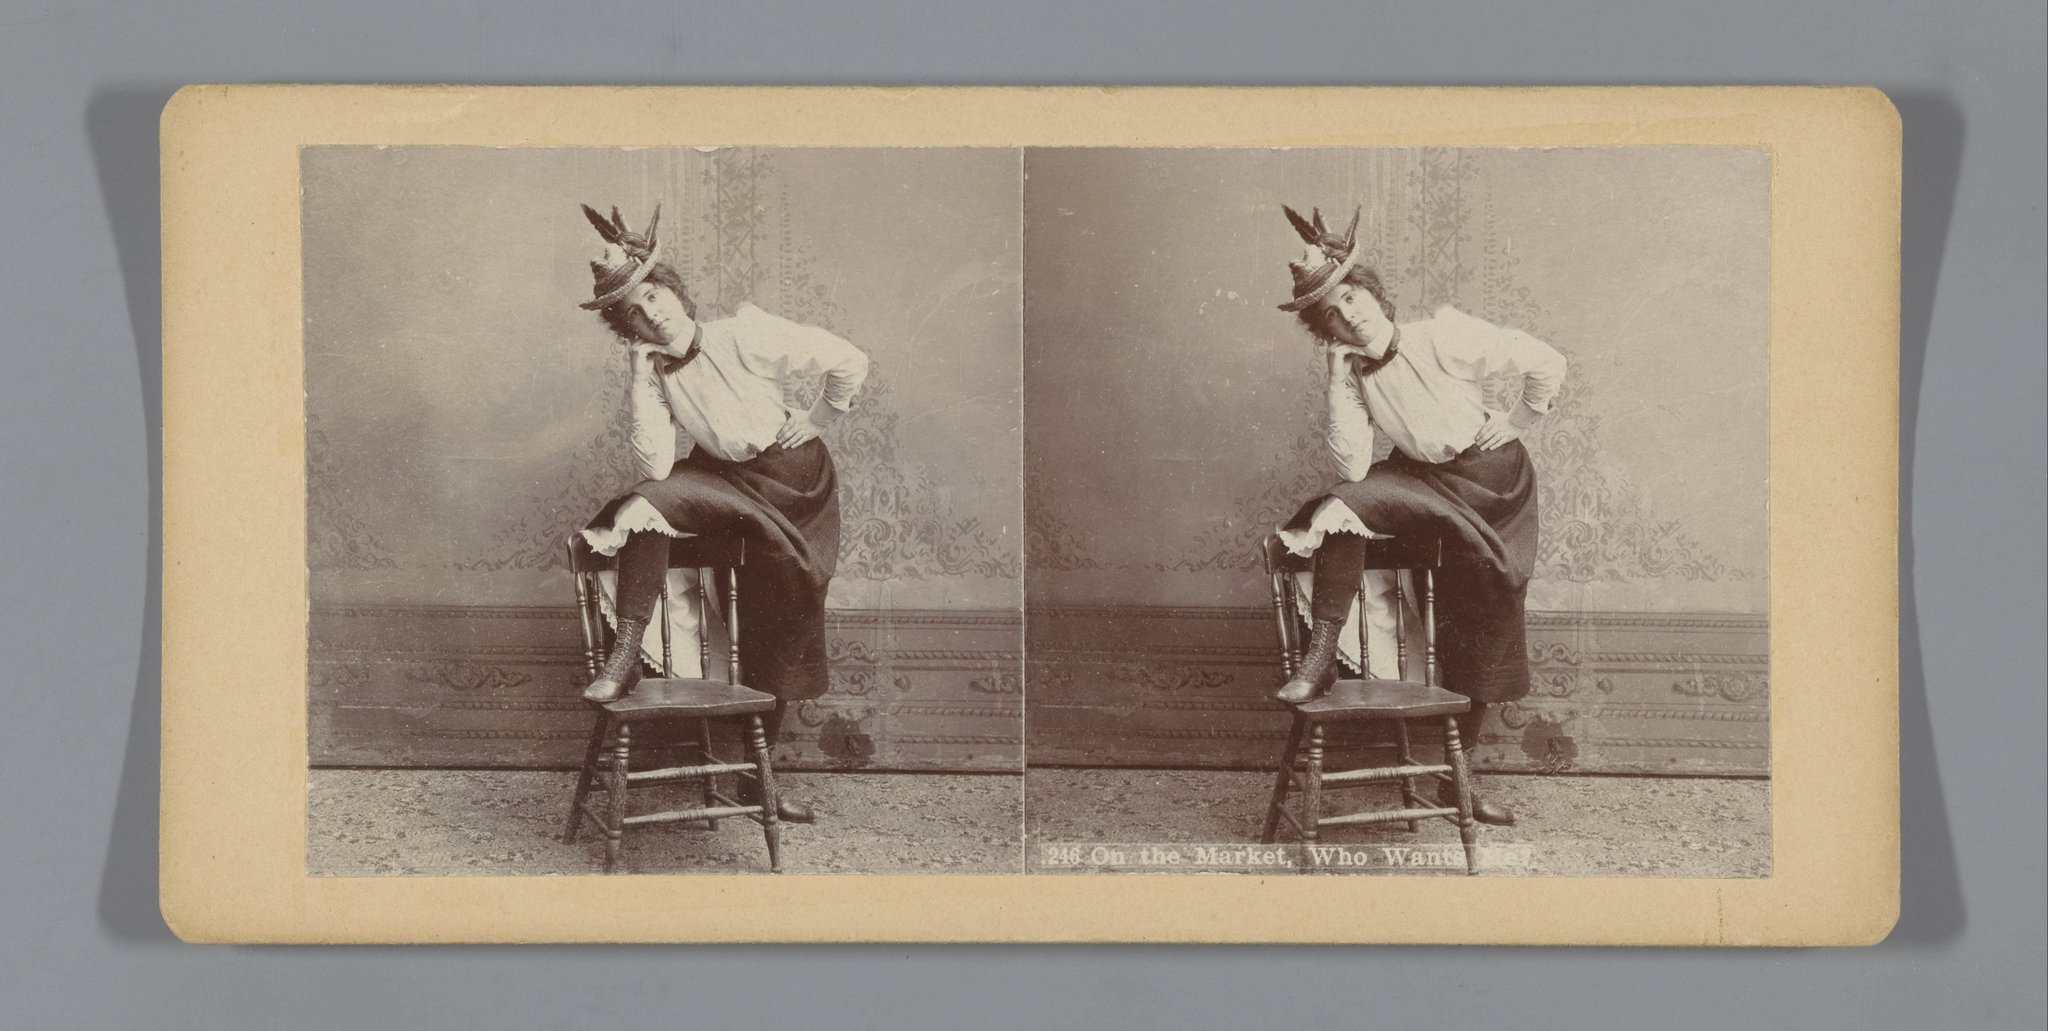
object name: stereograph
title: Vrouw poseert met één been op een stoel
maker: Anonymous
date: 1900-1920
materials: paper, cardboard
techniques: gelatin silver print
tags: adult woman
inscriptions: number: ‘.246’